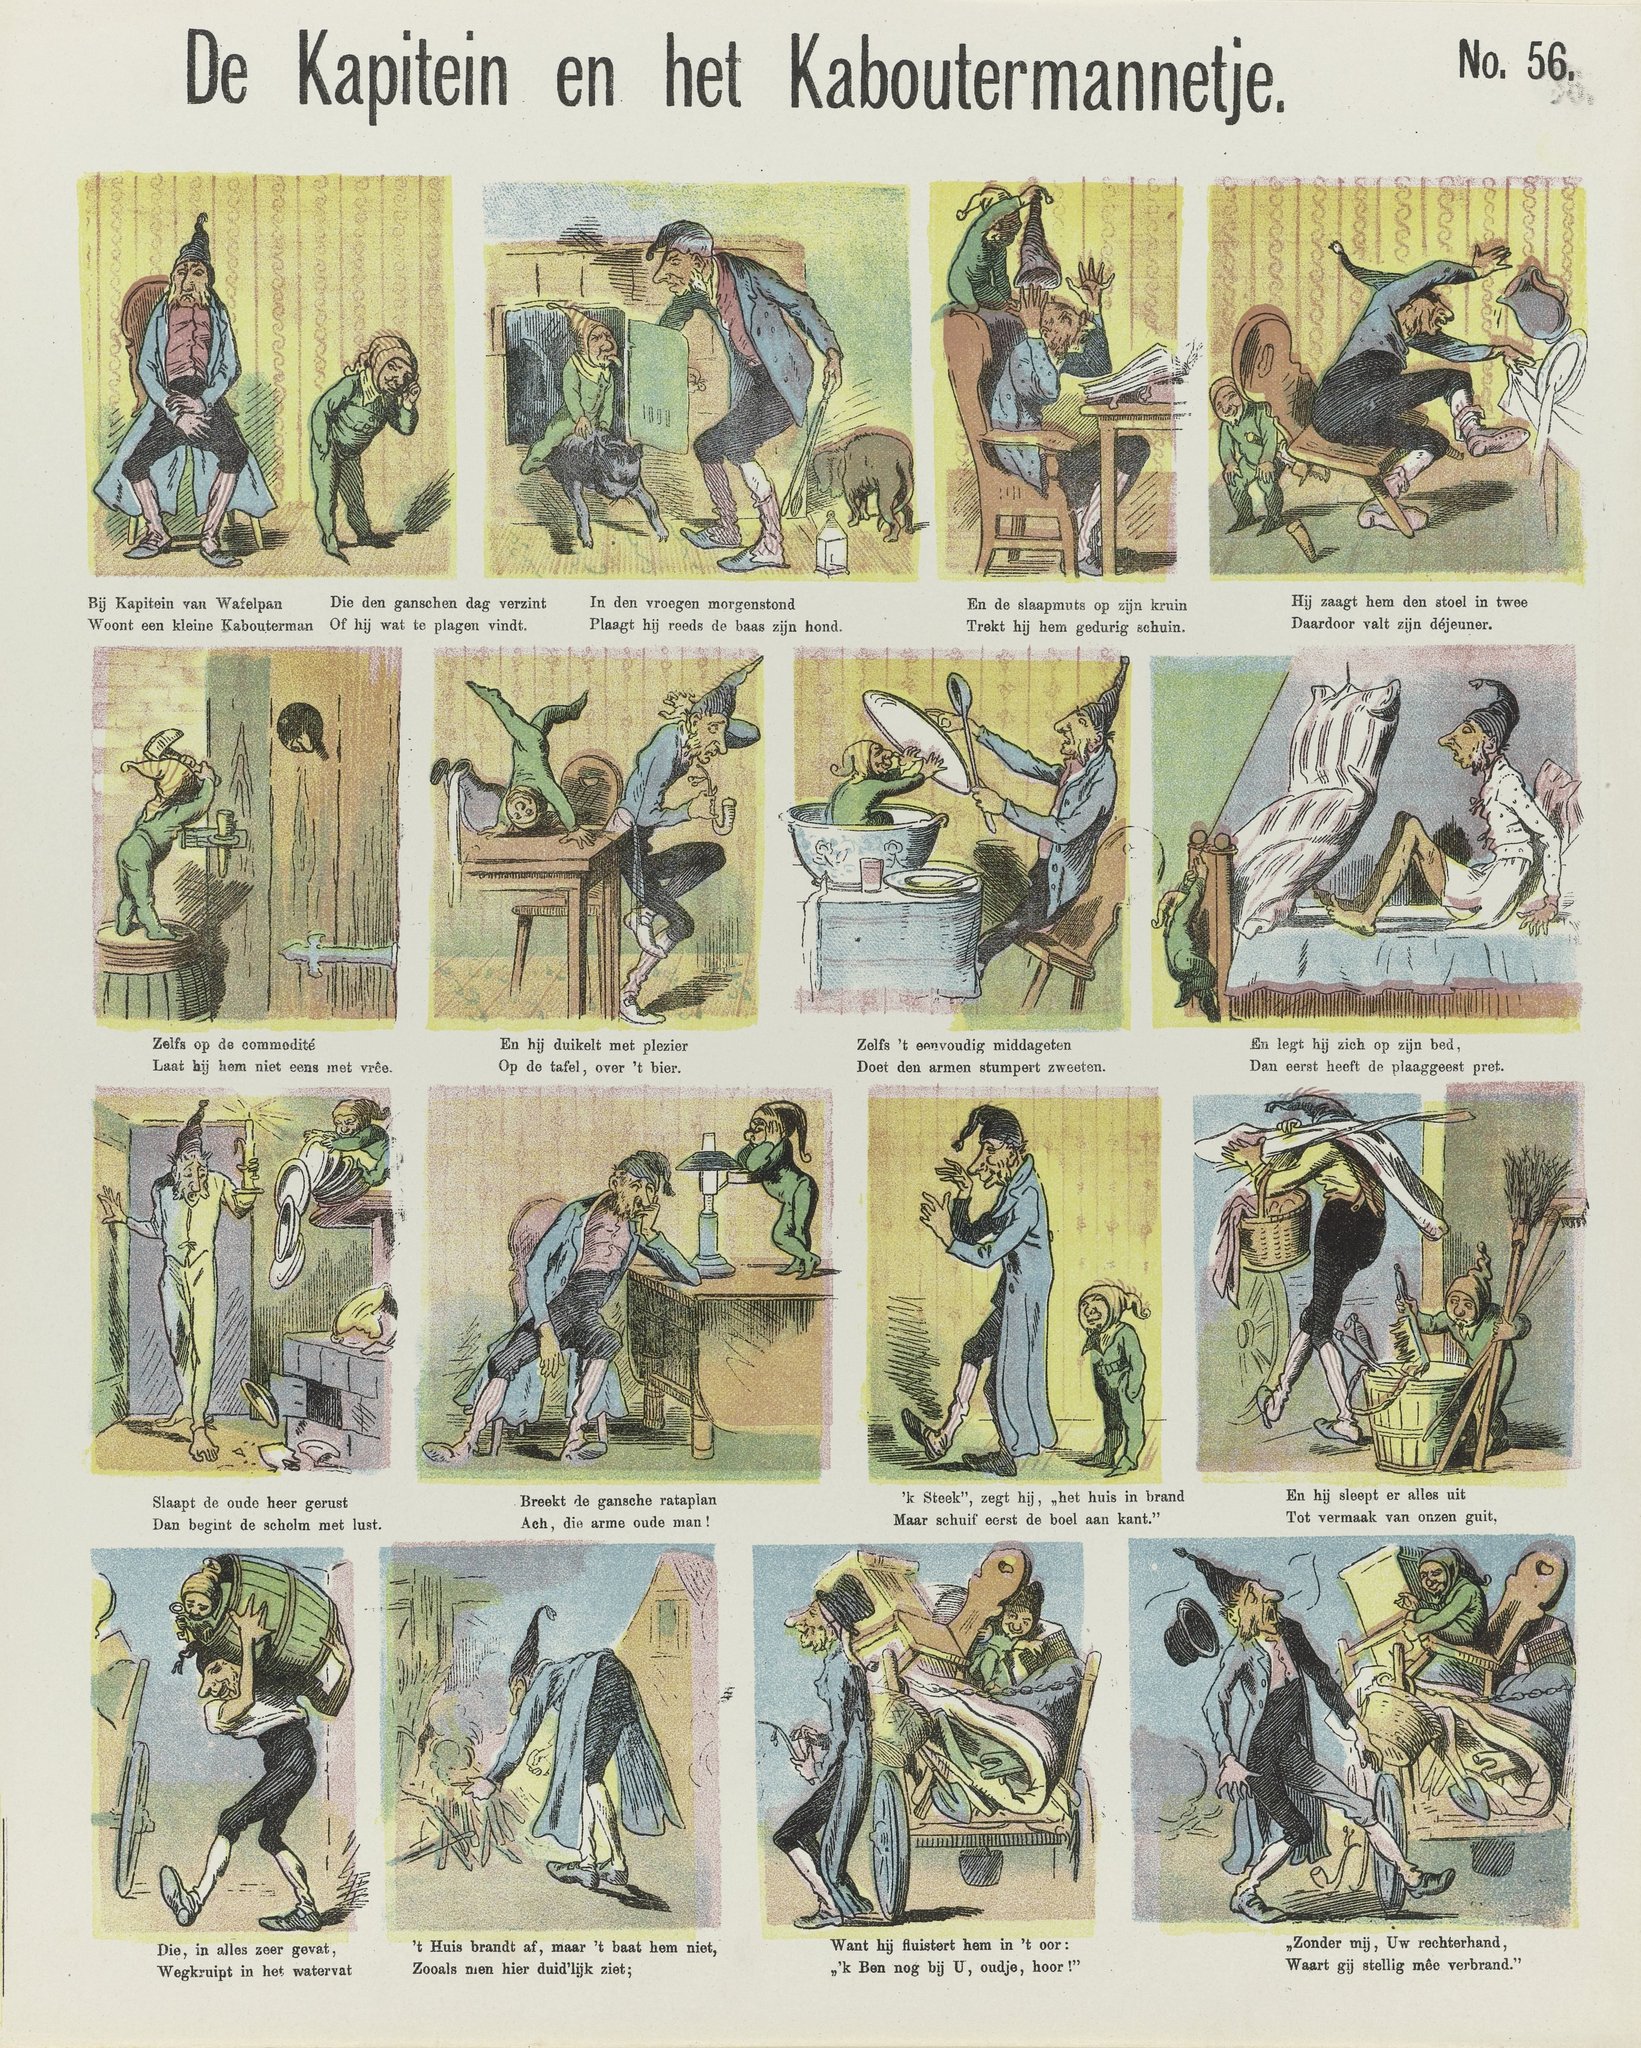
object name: popular print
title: Meijer's prenten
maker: Anonymous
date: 1878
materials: paper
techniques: lithograph, letterpress printing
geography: amsterdam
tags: tales and fairy tales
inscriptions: collector's mark: Lugt 2760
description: Blad met 16 komische voorstellingen over een kapitein die gepest wordt door een kabouter. Onder elke afbeelding een vers. Genummerd rechtsboven: No. 56.